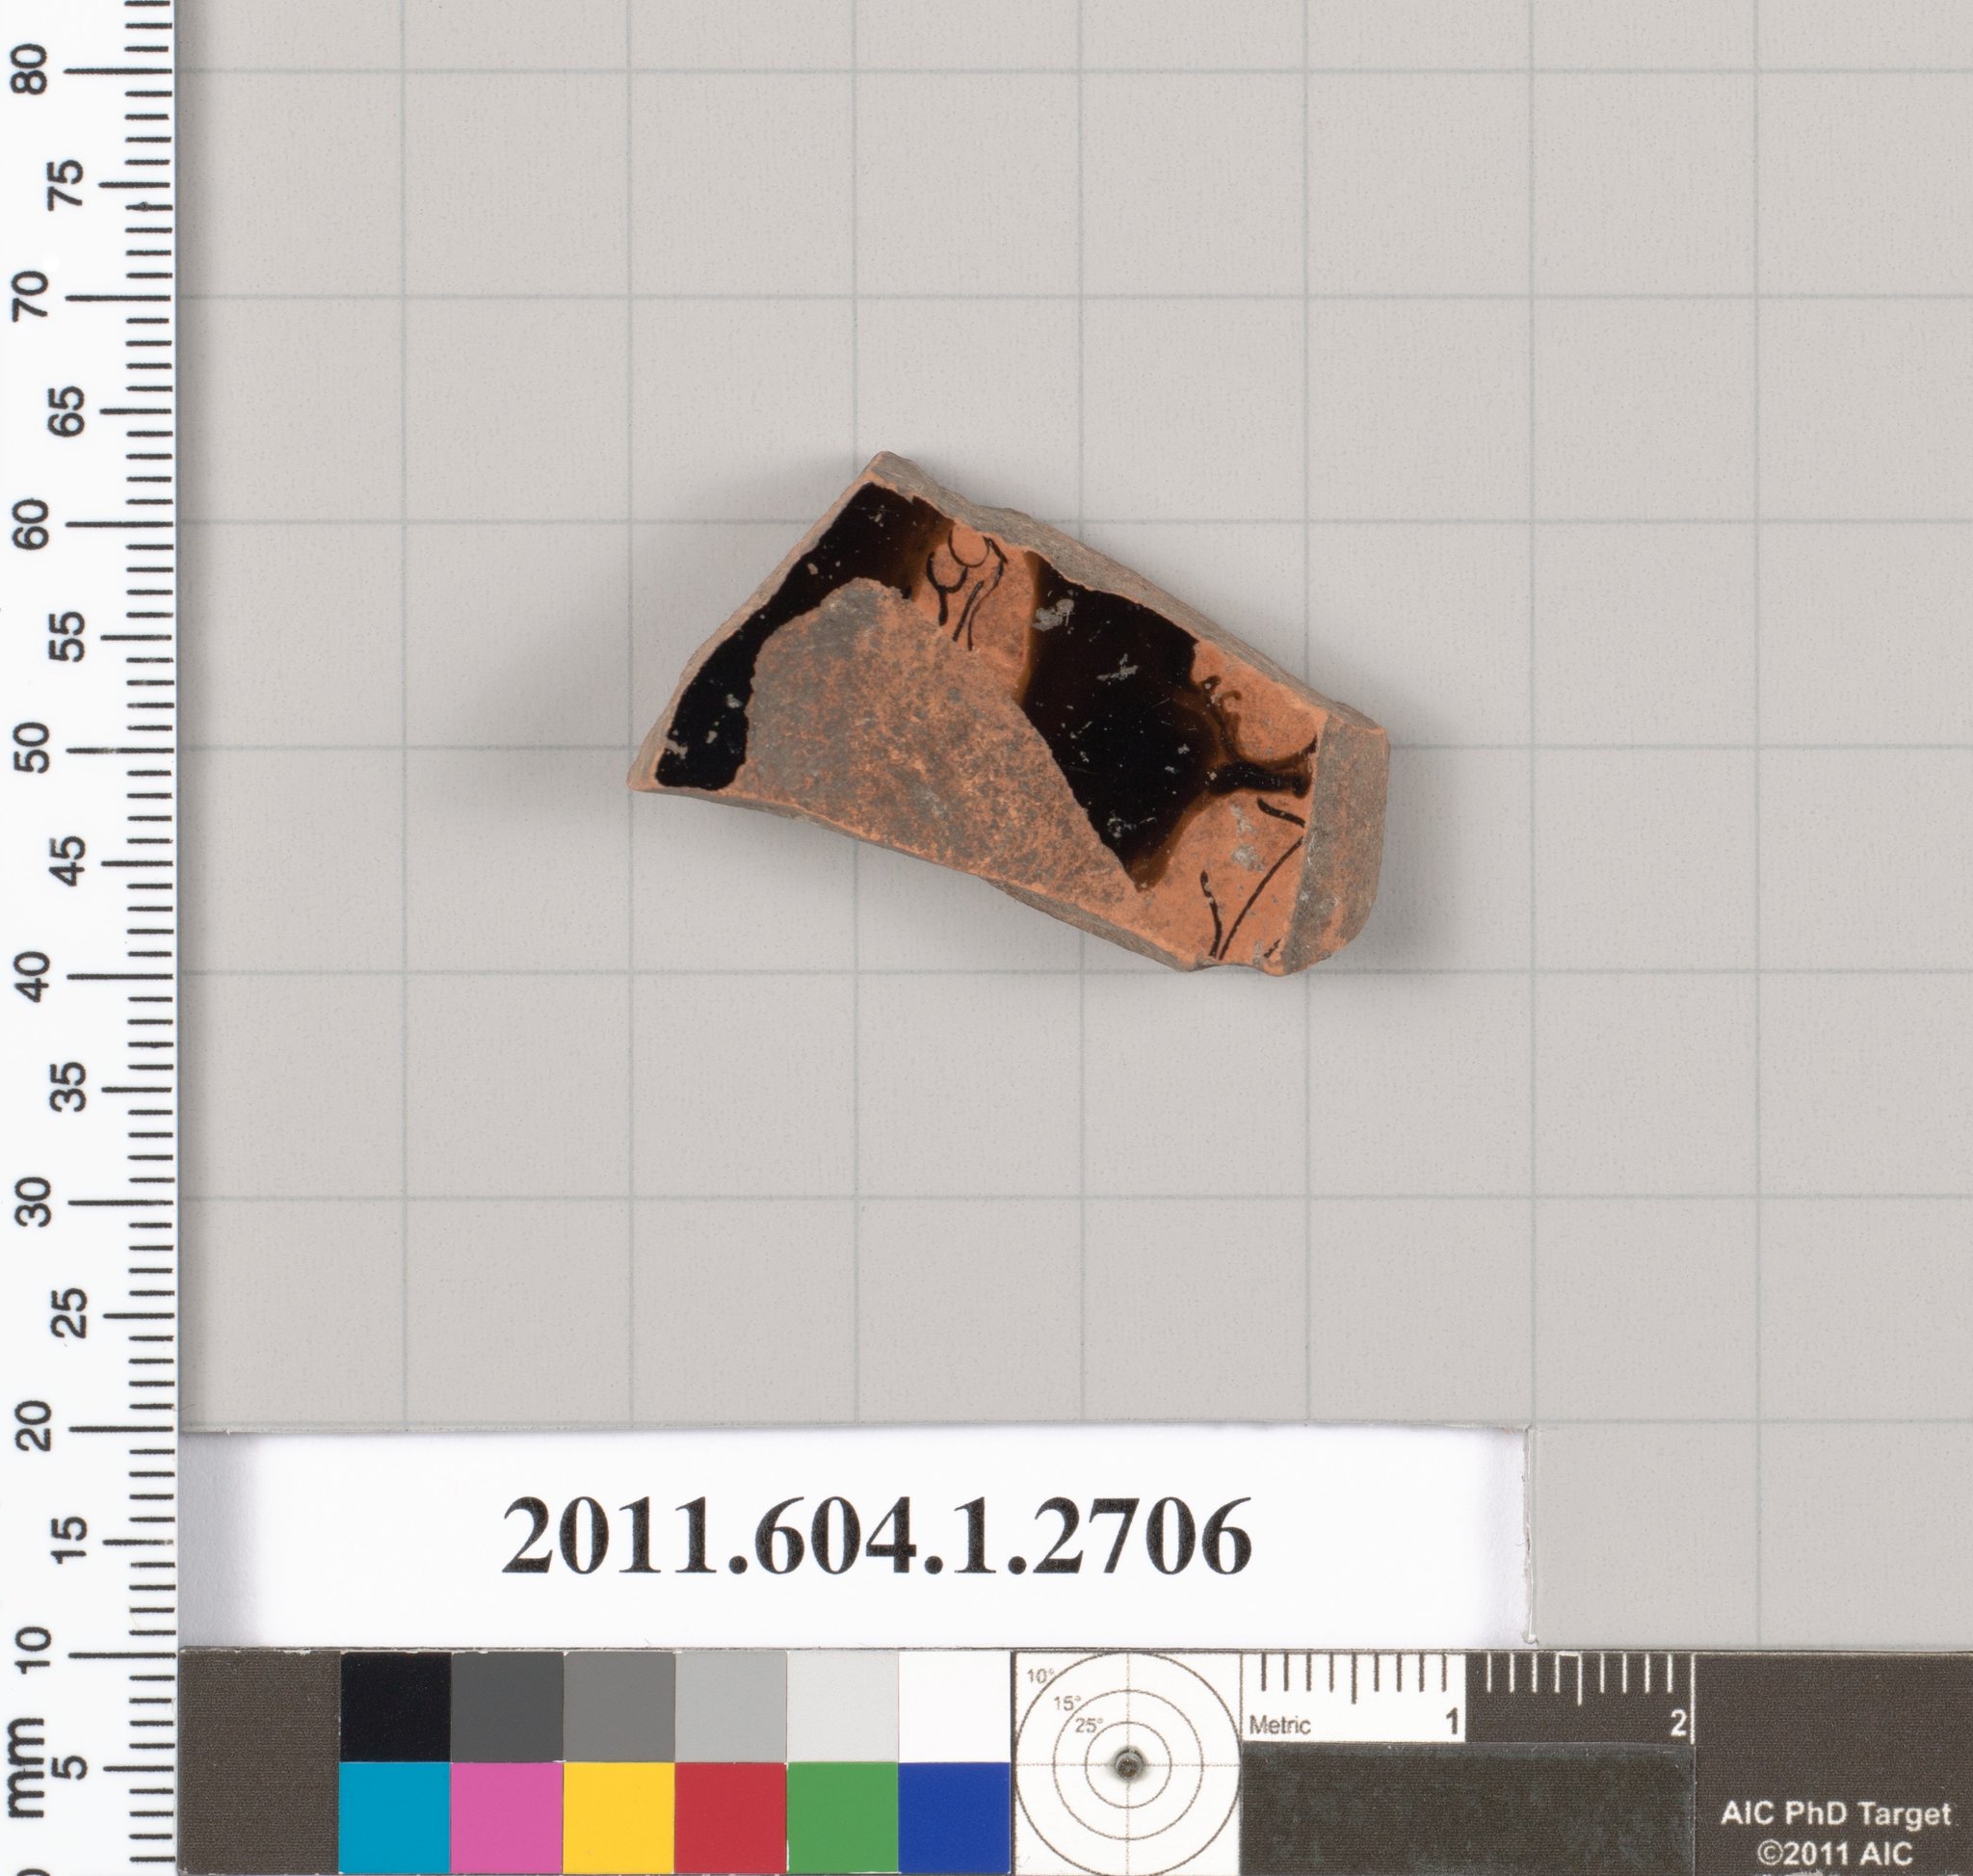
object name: kylix fragment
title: Terracotta fragment of a kylix (drinking cup)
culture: greek, attic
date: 480-470 BCE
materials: terracotta